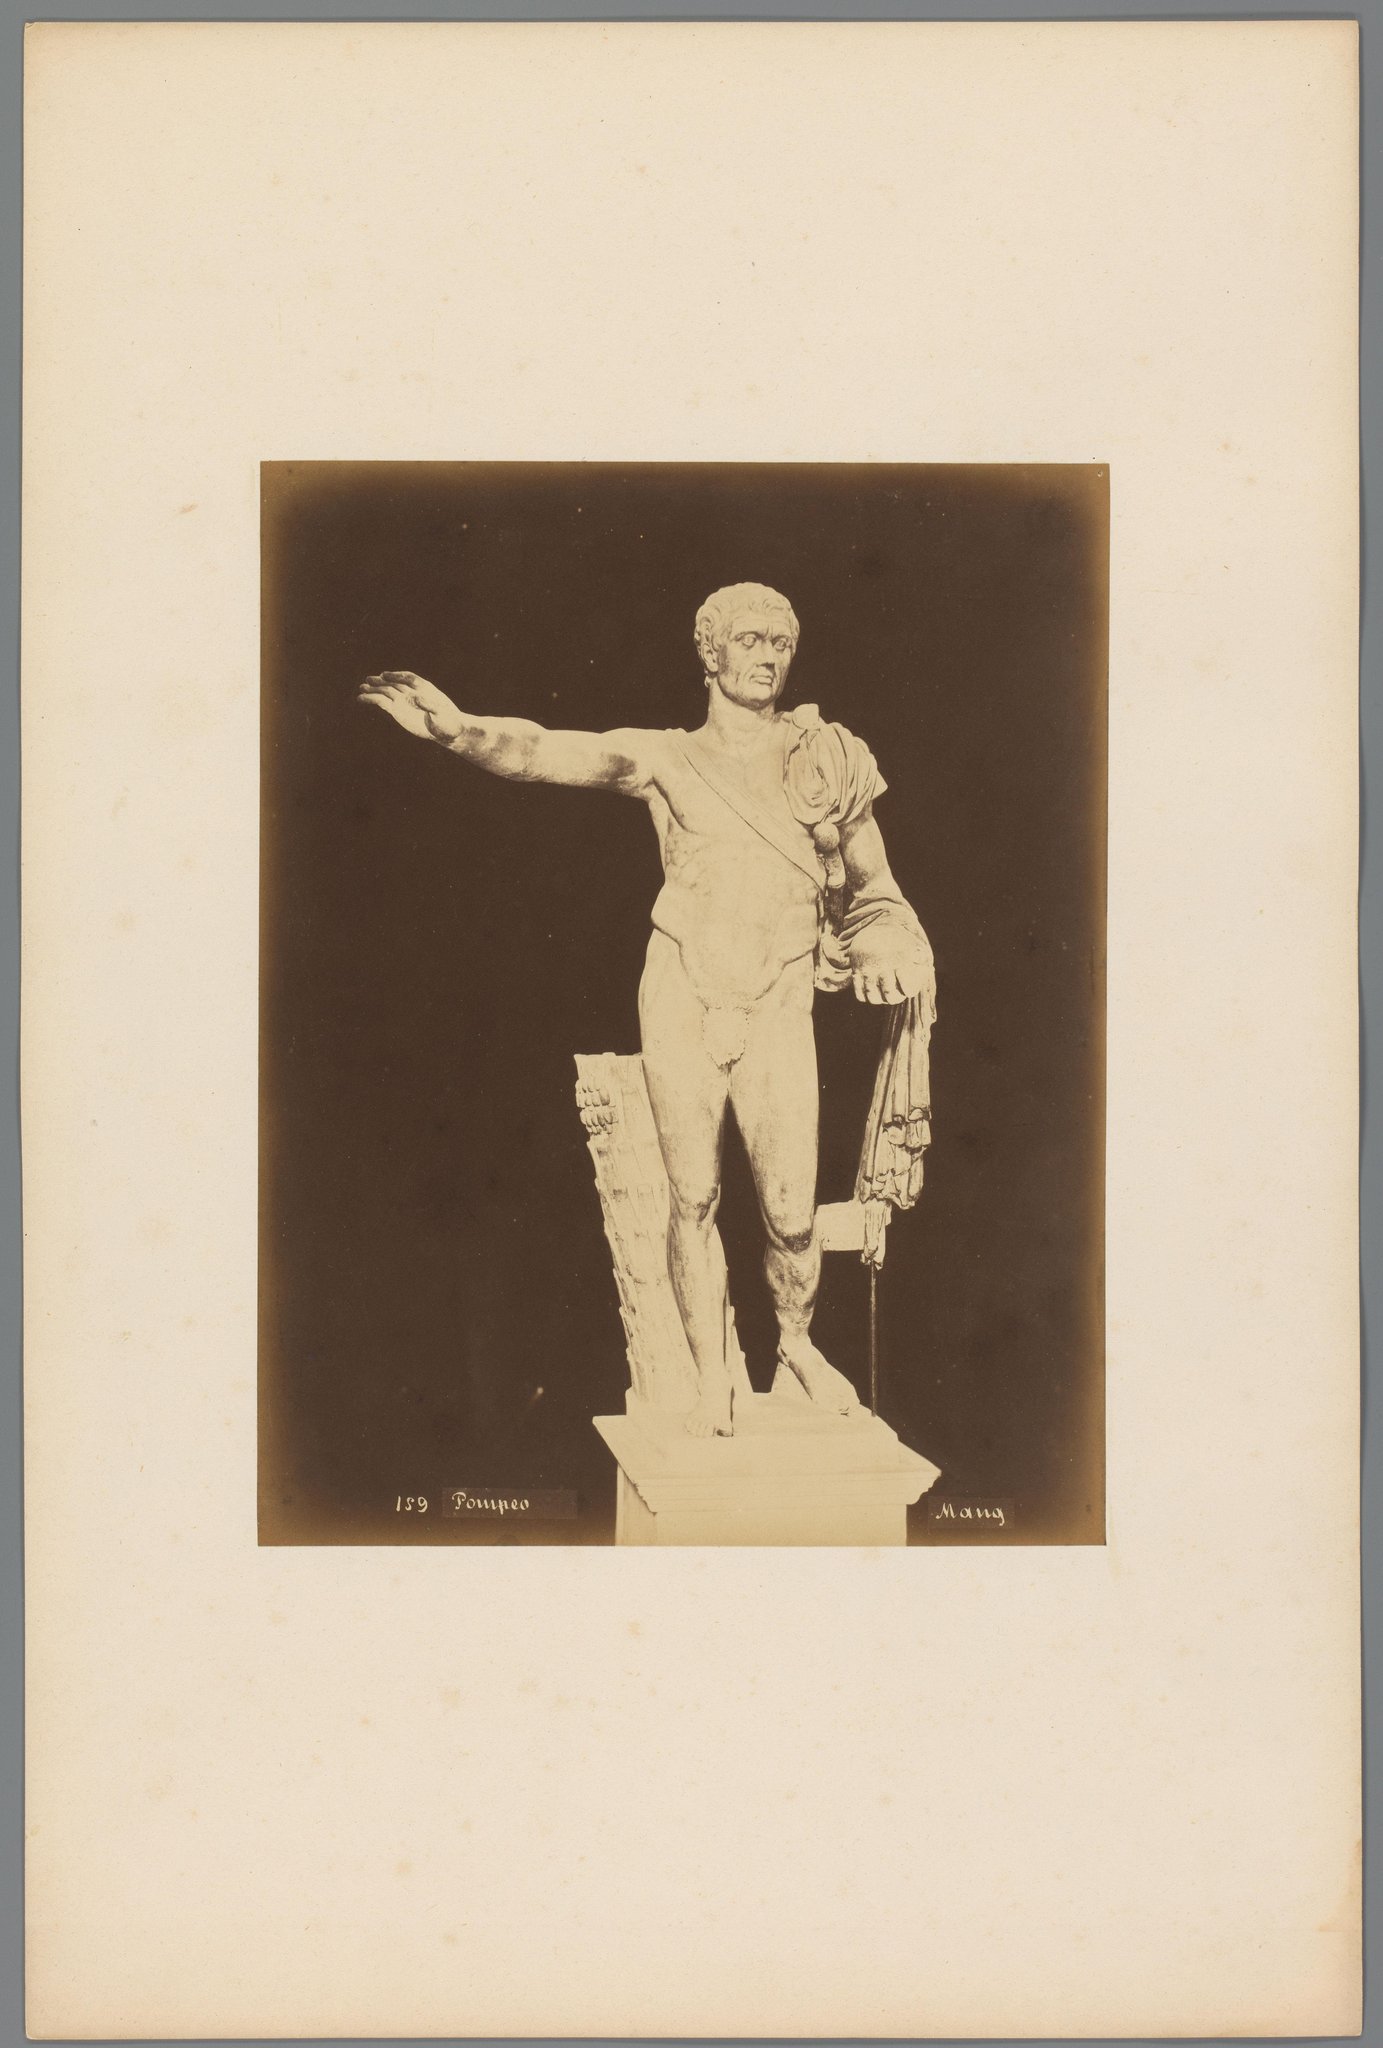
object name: photograph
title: Sculptuur van Pompeius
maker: michèle mang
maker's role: fotograaf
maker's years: 1840-1909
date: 1863-1887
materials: cardboard, paper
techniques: albumen print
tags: rome, politician, piece of sculpture, reproduction of a piece of sculpture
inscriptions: number: ‘159’